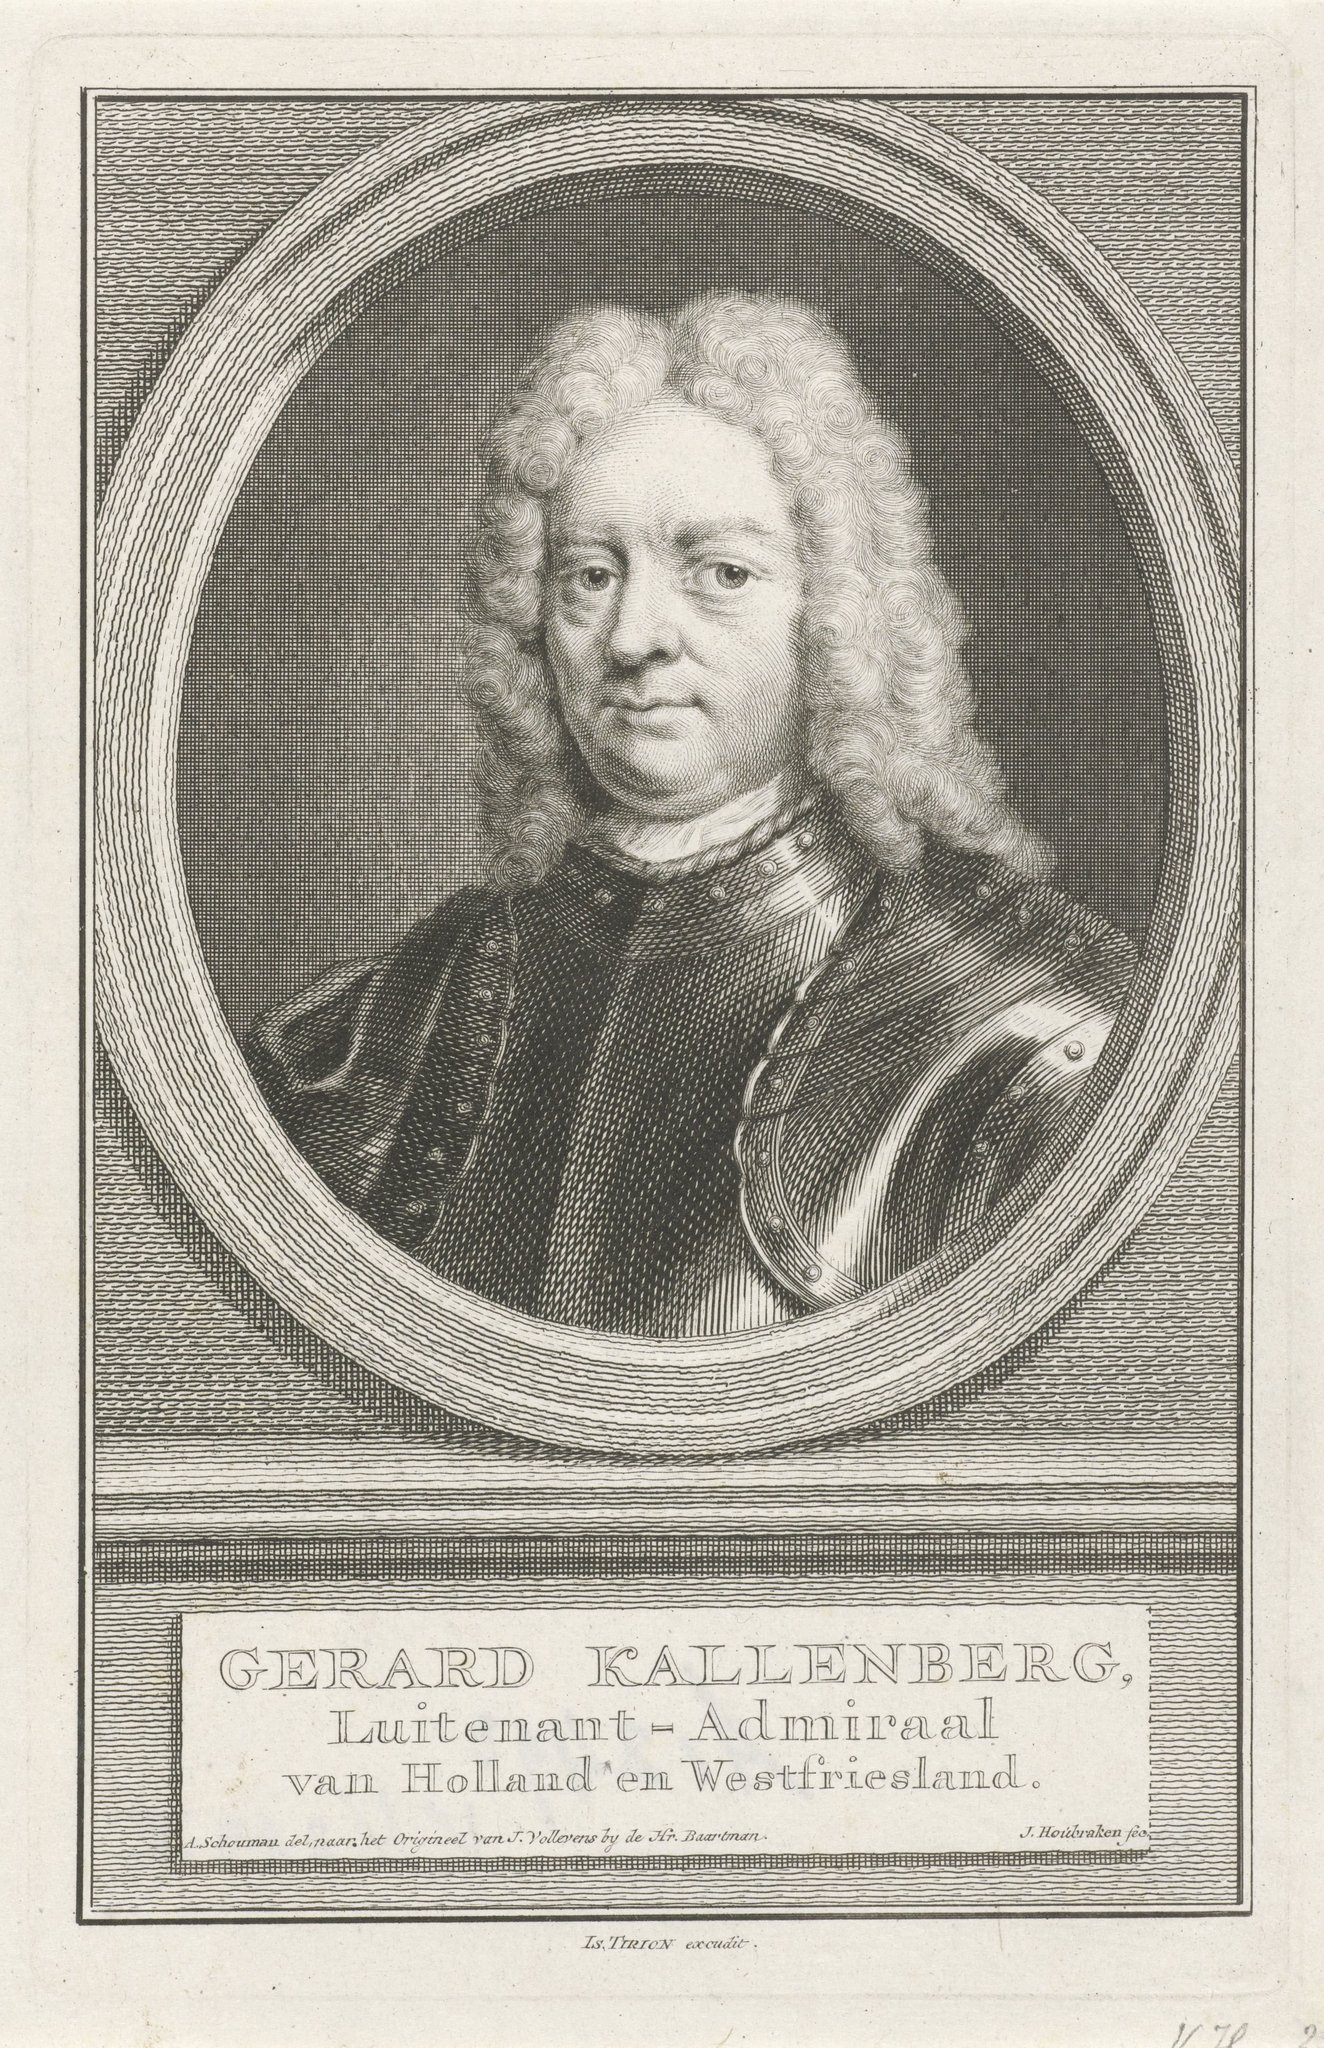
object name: print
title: Portret van Gerard Callenburgh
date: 1749-1759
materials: paper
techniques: engraving, etching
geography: amsterdam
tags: flushing, gerard callenburgh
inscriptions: collector's mark: Lugt 2228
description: Prent ook gebruikt in: Jan Wagenaar, Vaderlandsche historie, vervattende de geschiedenissen der nu Vereenigde Nederlanden, inzonderheid die van Holland (...), 21 delen. Amsterdam, Isaak Tirion, 1749-59.